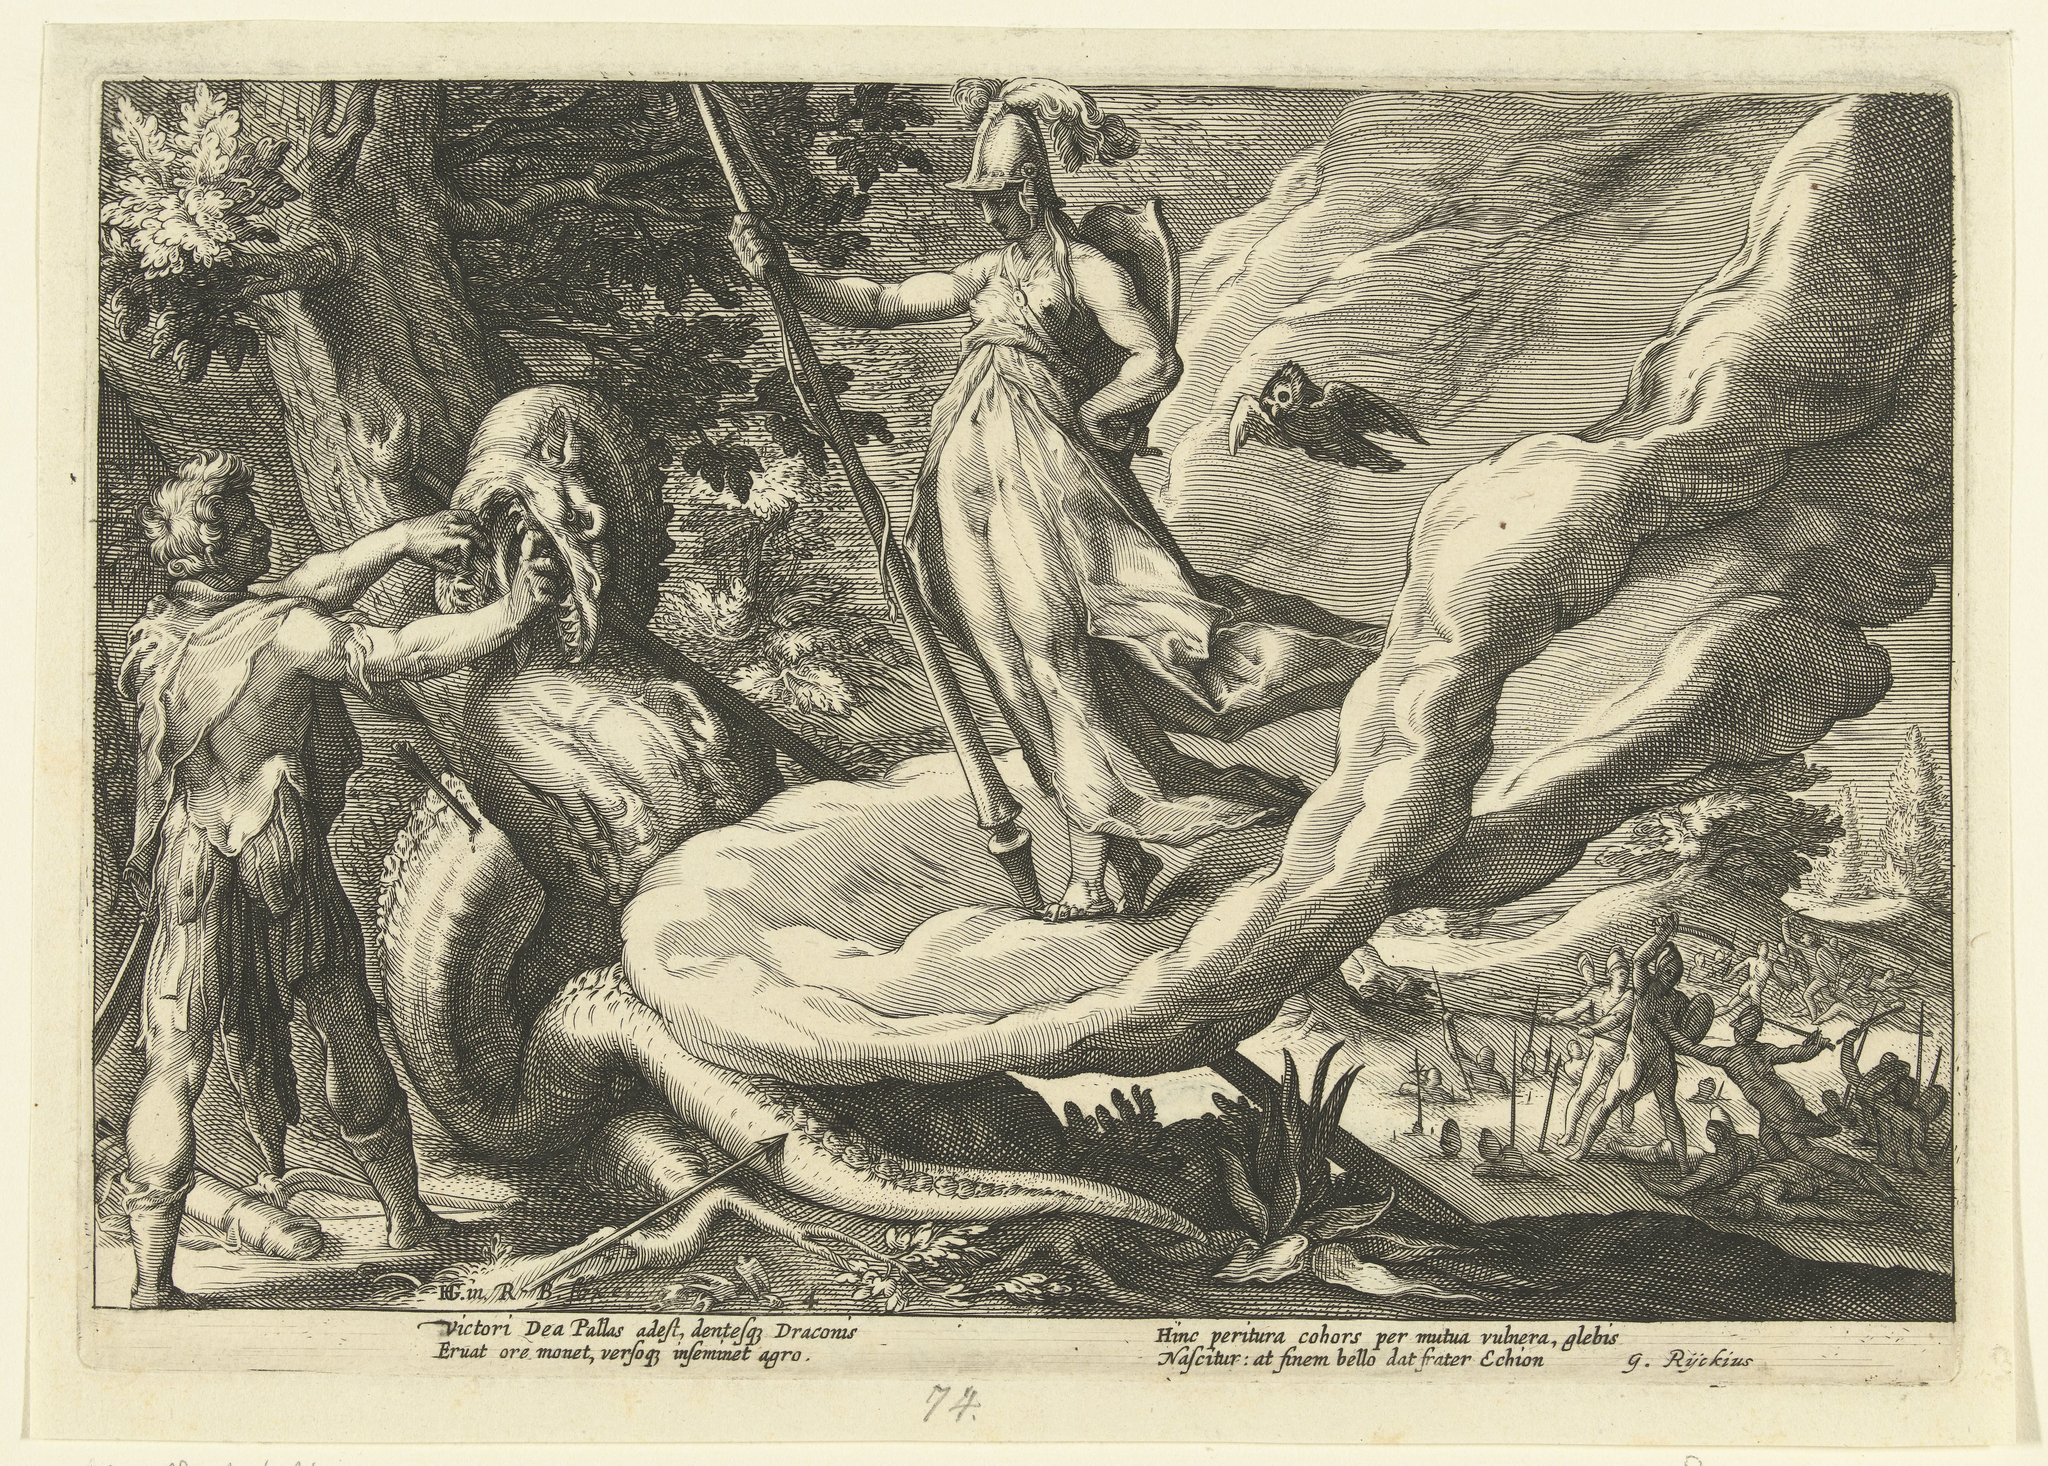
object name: print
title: Cadmus zaait de tanden van de draak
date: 1615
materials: paper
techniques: engraving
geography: netherlands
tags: on minerva's advice, cadmus sows the dragon's teeth; a host of armed men springs up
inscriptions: collector's mark: Lugt 2398, collector's mark: Lugt 2510, collector's mark: Lugt 1606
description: Minerva draagt Cadmus op om een deel van de tanden van de draak die hij zojuist gedood heeft te zaaien. Dat doet hij, waarop gewapende mannen uit de aarde oprijzen. Onder de voorstelling twee keer twee regels Latijnse tekst. Deze prent is onderdeel van een serie van 52 prenten die verhalen uit Ovidius' Metamorfosen verbeelden. Deze serie valt uiteen in drie genummerde reeksen: twee van 20 prenten en één van 12 prenten. Deze prent behoort tot de derde reeks.